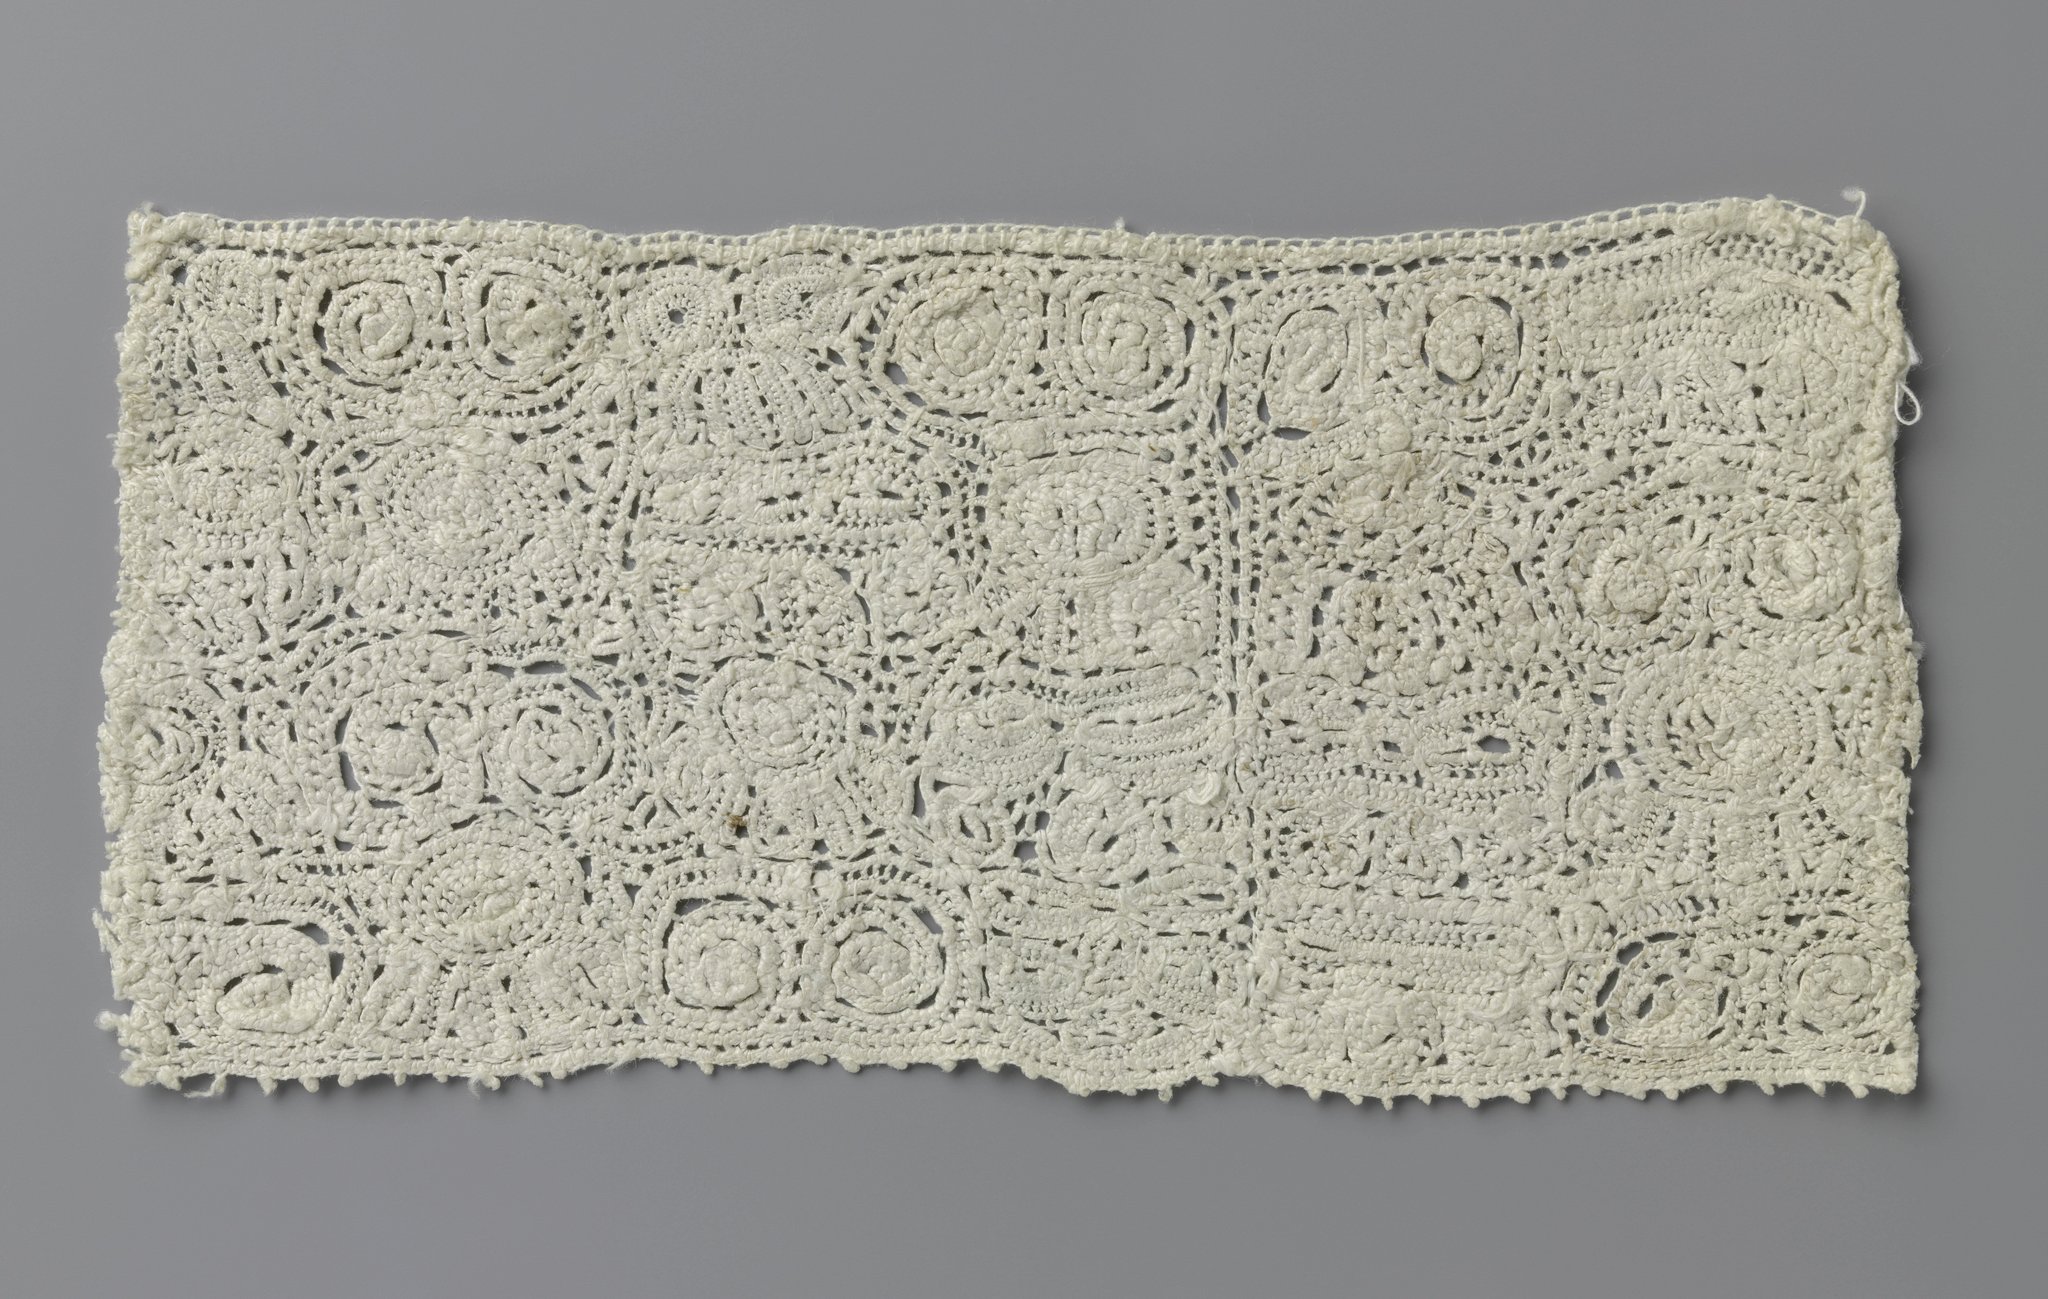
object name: strip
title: Strook naaldkant met spiralen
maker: Anonymous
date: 1600-1699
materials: linen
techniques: needle lace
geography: italy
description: Strook naturelkleurig naaldkant. Patroon met dichtopeen gedrongen voluten en palmetten, zonder grond. Het volwerk bestaat uit dikke contourdraden die spiraalsgewijs gelegd zijn, waarbij verbindingen zijn gemaakt door gedraaide festonsteken in één toer-hoogte. De boven- en onderzijde zijn afgewerkt met een rechte rand, aan de onderzijde hangen echter zeer kleine steeltjes of puntjes. De korte zijden zijn gestikt om rafelen te voorkomen.